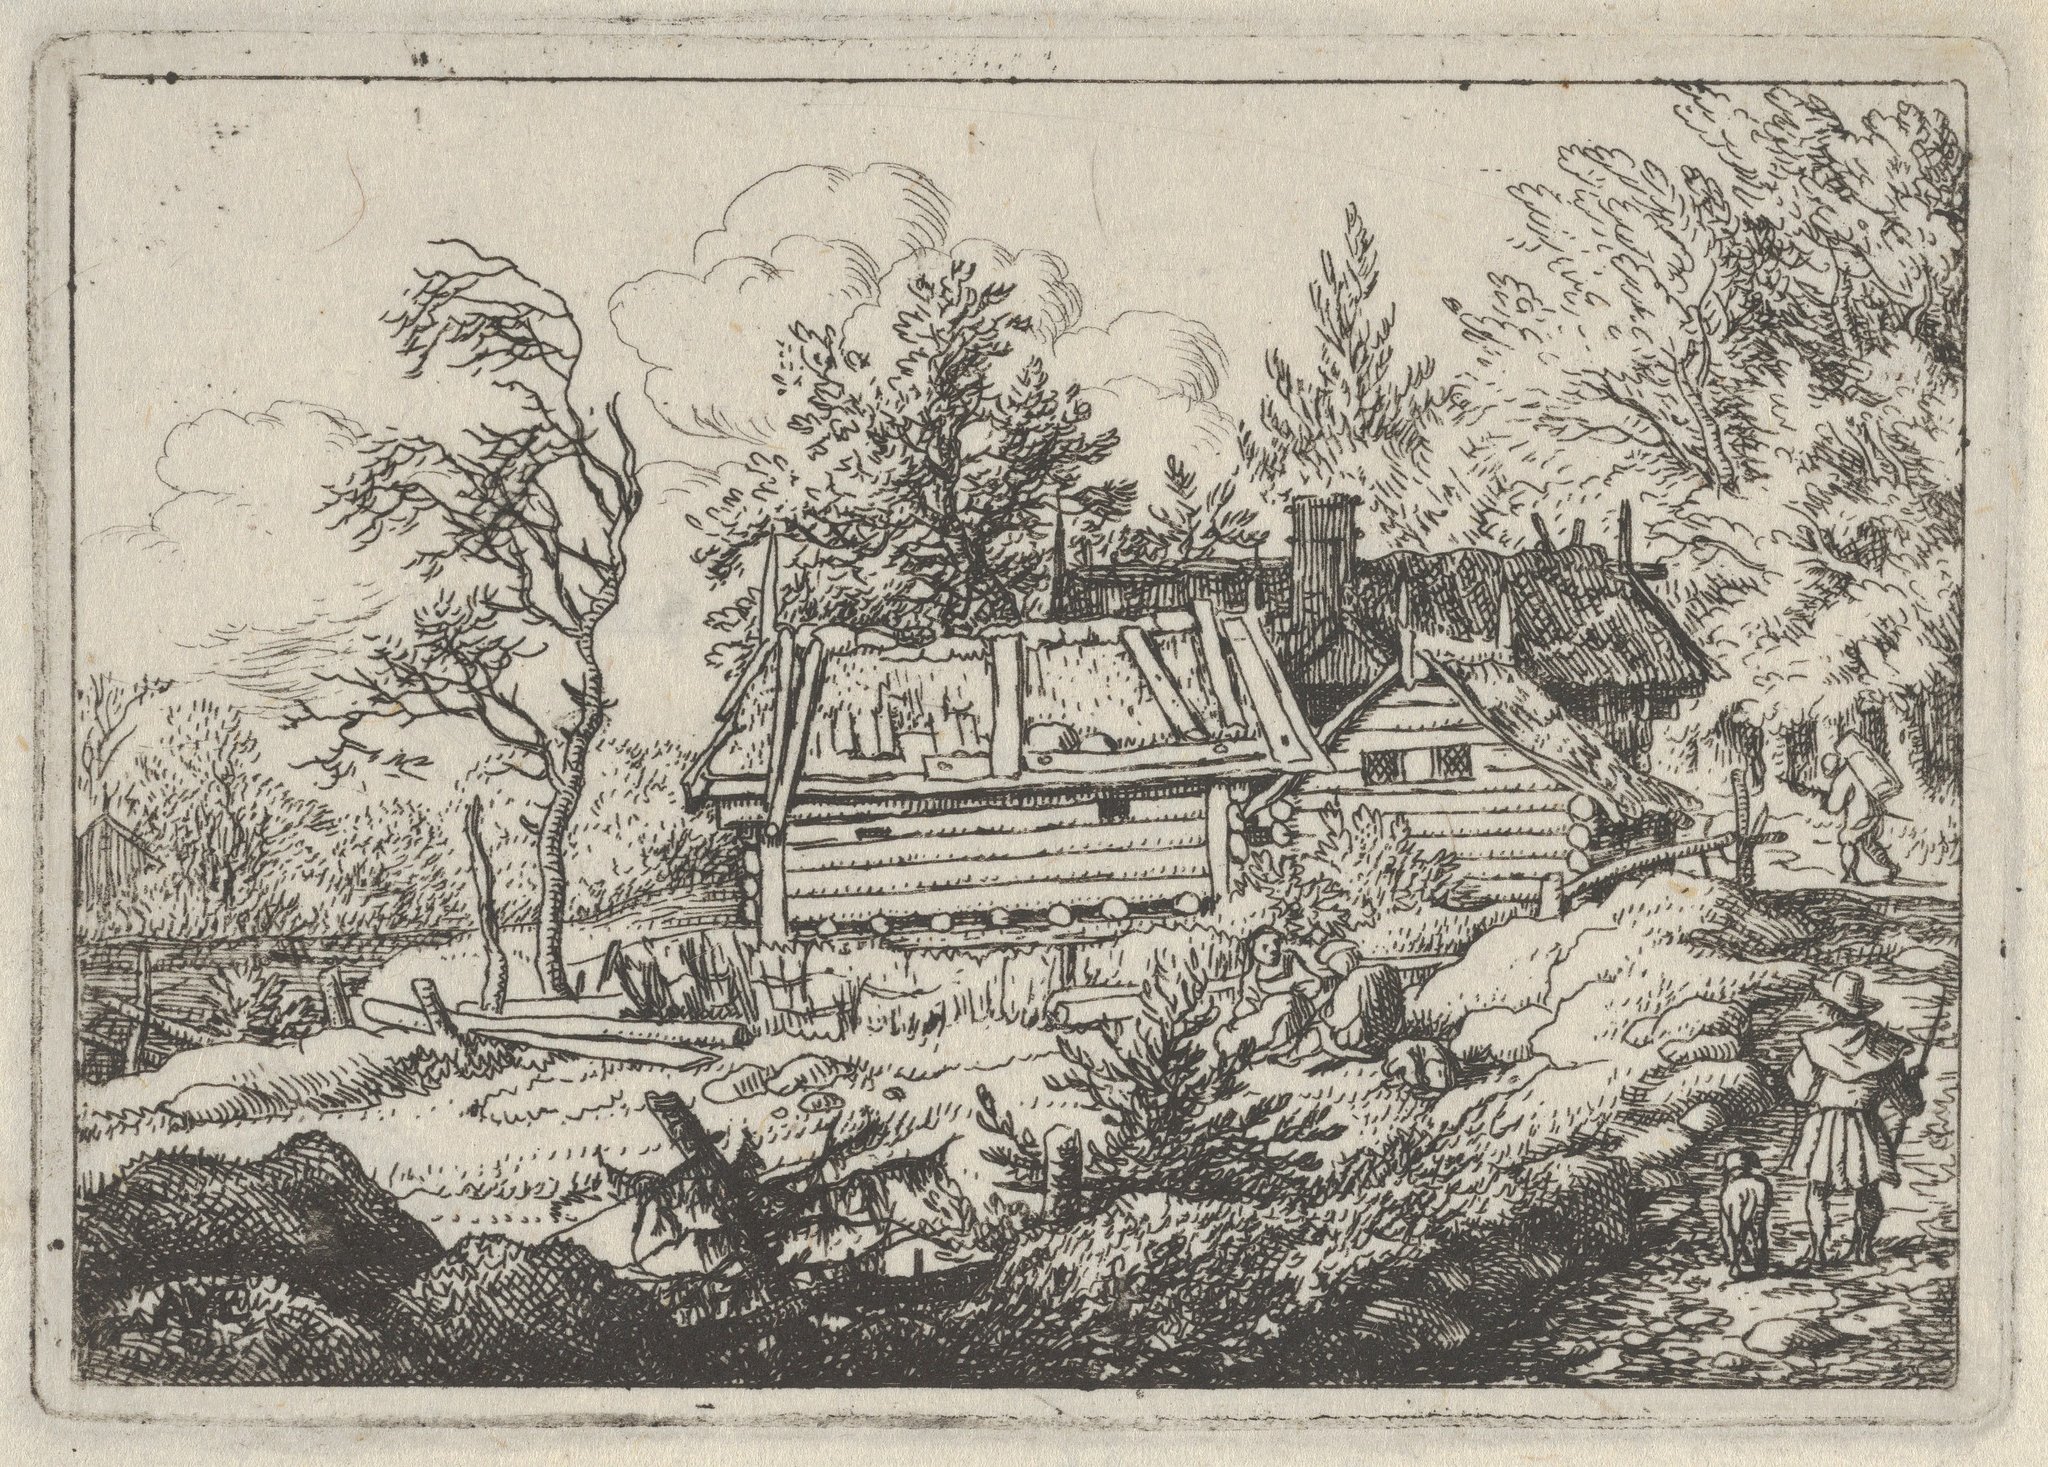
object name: print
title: The Pilgrim with the Dog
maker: allart van everdingen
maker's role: artist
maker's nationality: dutch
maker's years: 1621-1675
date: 1621-1675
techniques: engraving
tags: houses,men,dogs,landscapes